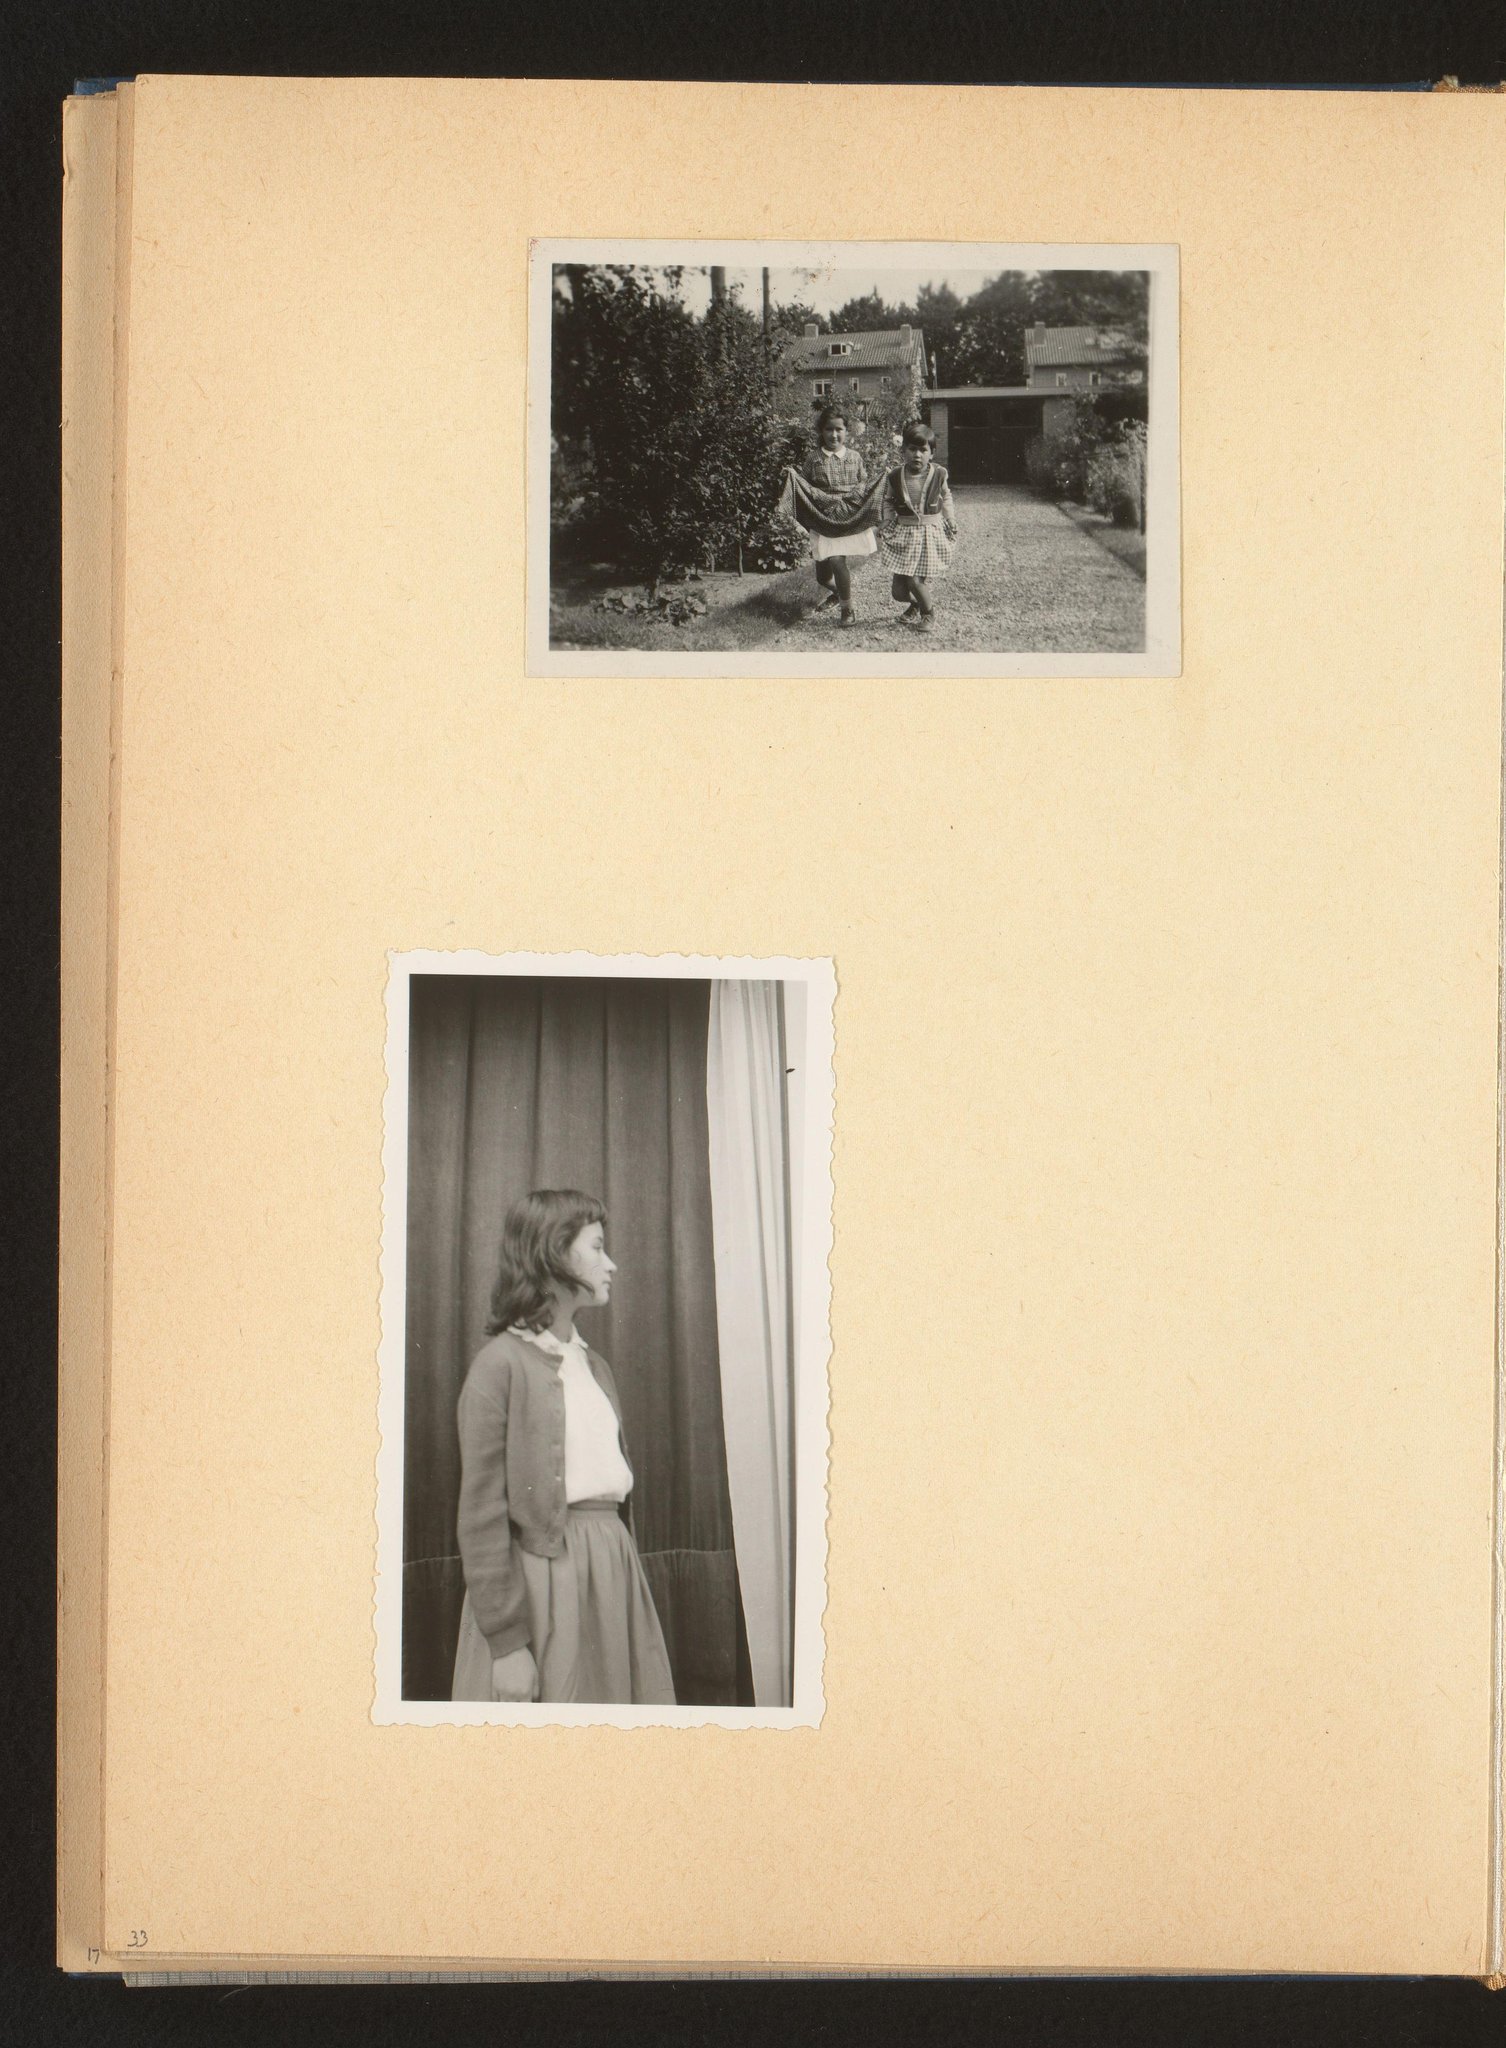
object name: album leaf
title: Dochters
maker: Anonymous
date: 1946-1952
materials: cardboard, photographic support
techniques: gelatin silver print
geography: netherlands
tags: paris, beatrice jacqueline eveline dumas, historical persons - bb - woman, girl (child between toddler and youth), netherlands, dutch east indies, the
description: Blad met twee foto's van de dochters van Eef Dumas. Onderdeel van het fotoalbum van Beatrice Jacqueline Eveline (Eef) Dumas, ca. 1880-1952.